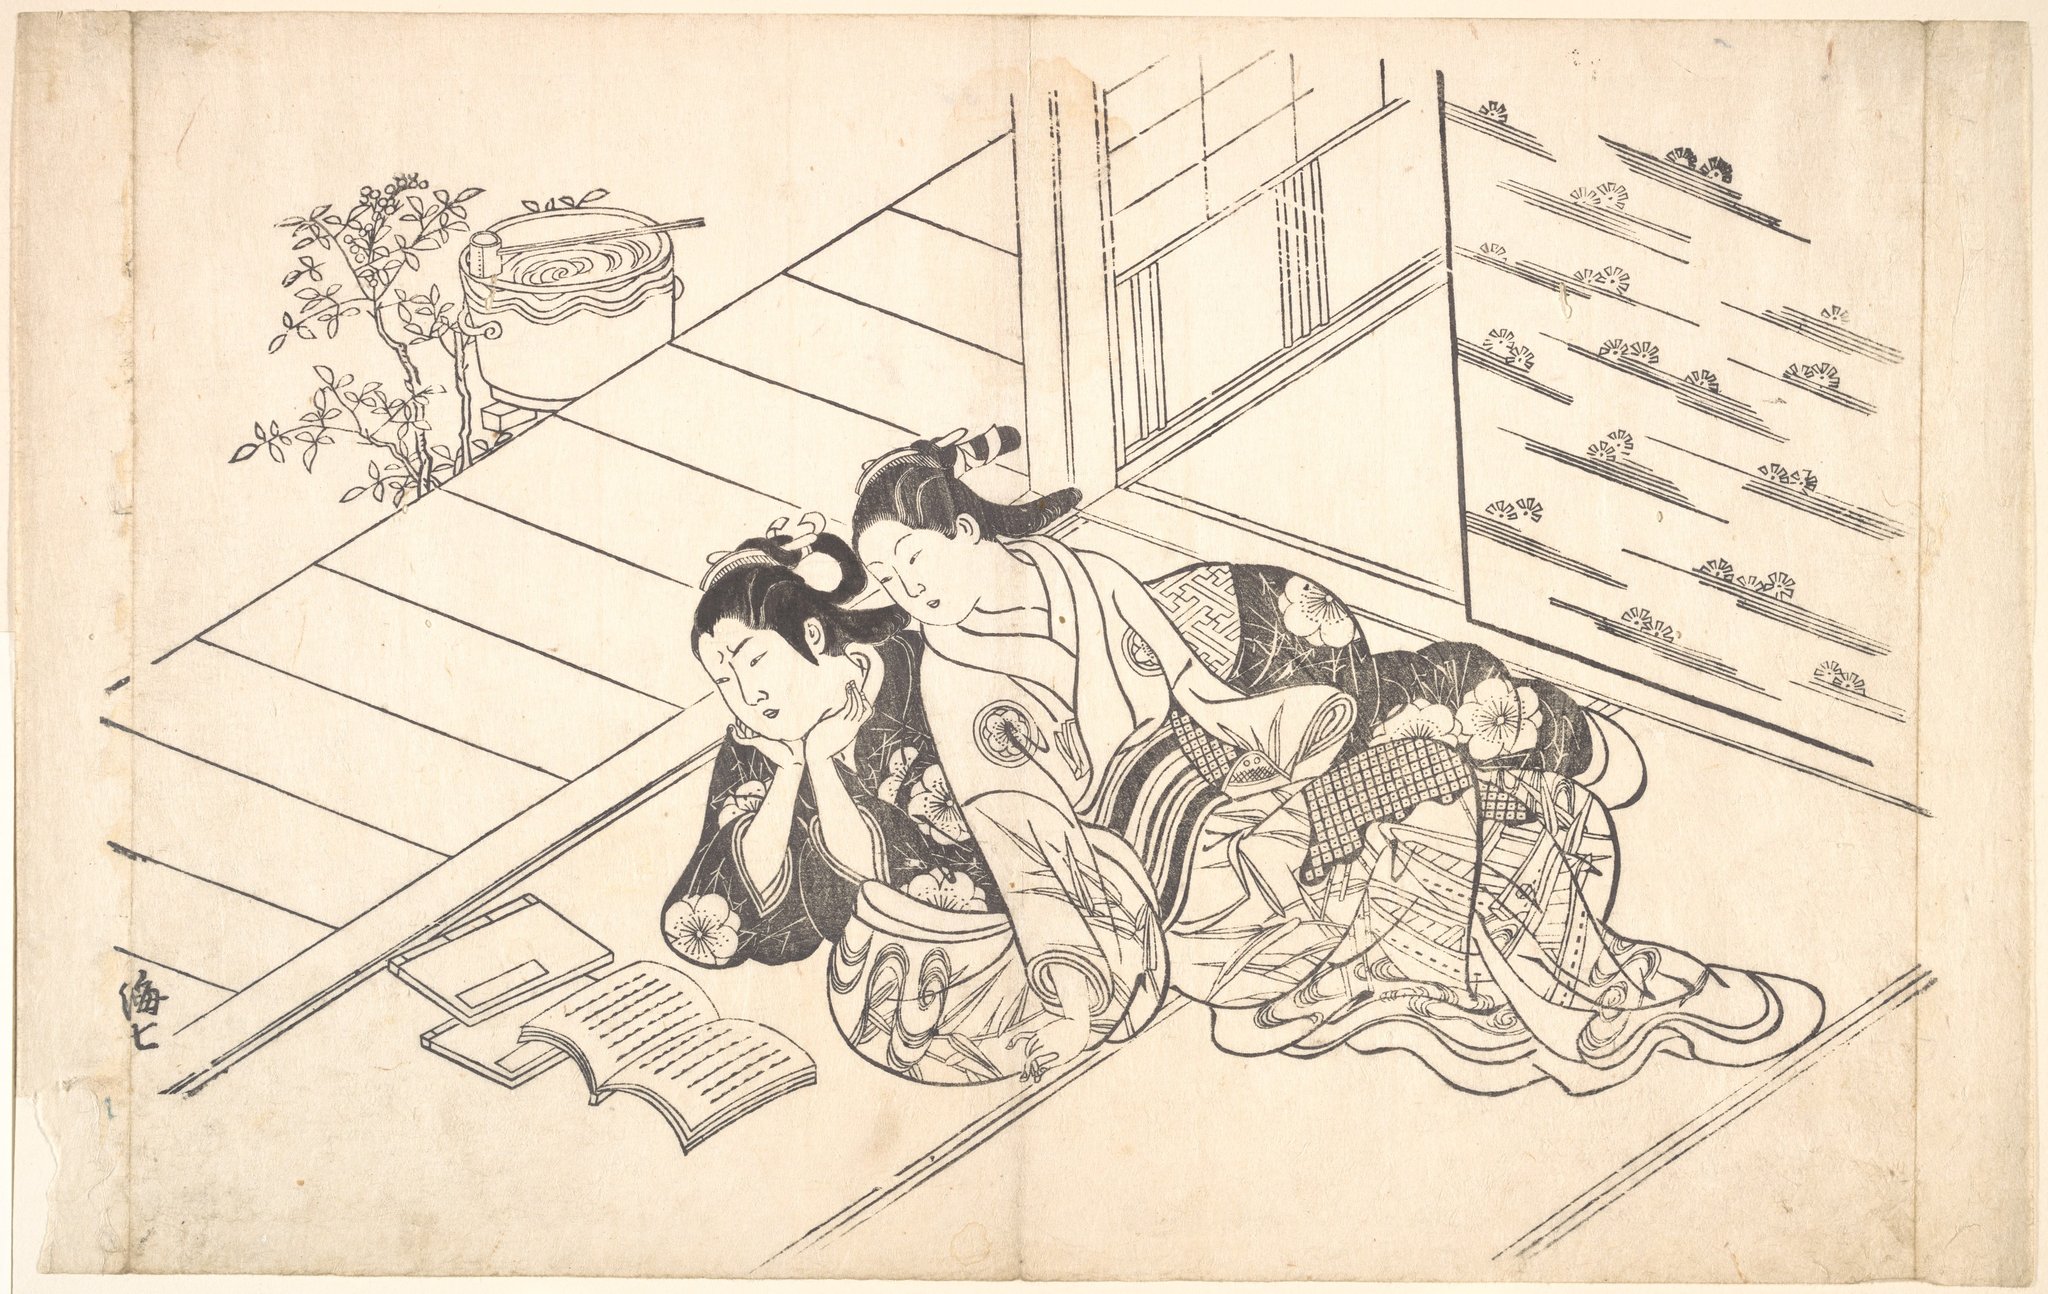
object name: woodblock print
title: Two Women Reclining on the Floor of a Room and Reading a Book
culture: japanese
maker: nishikawa sukenobu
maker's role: artist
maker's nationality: japanese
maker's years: 1671-1750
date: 1730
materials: ink, paper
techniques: woodblock print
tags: books,women,reading